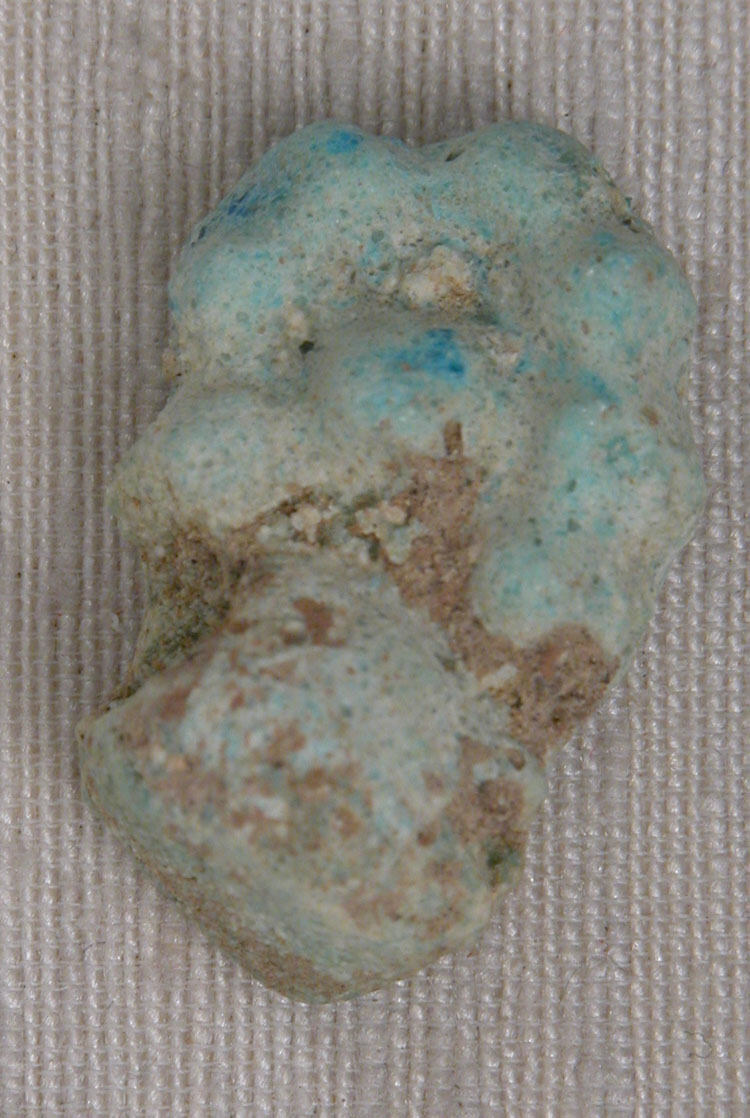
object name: bead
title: Beads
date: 701-1300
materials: earthenware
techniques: glazing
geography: iran